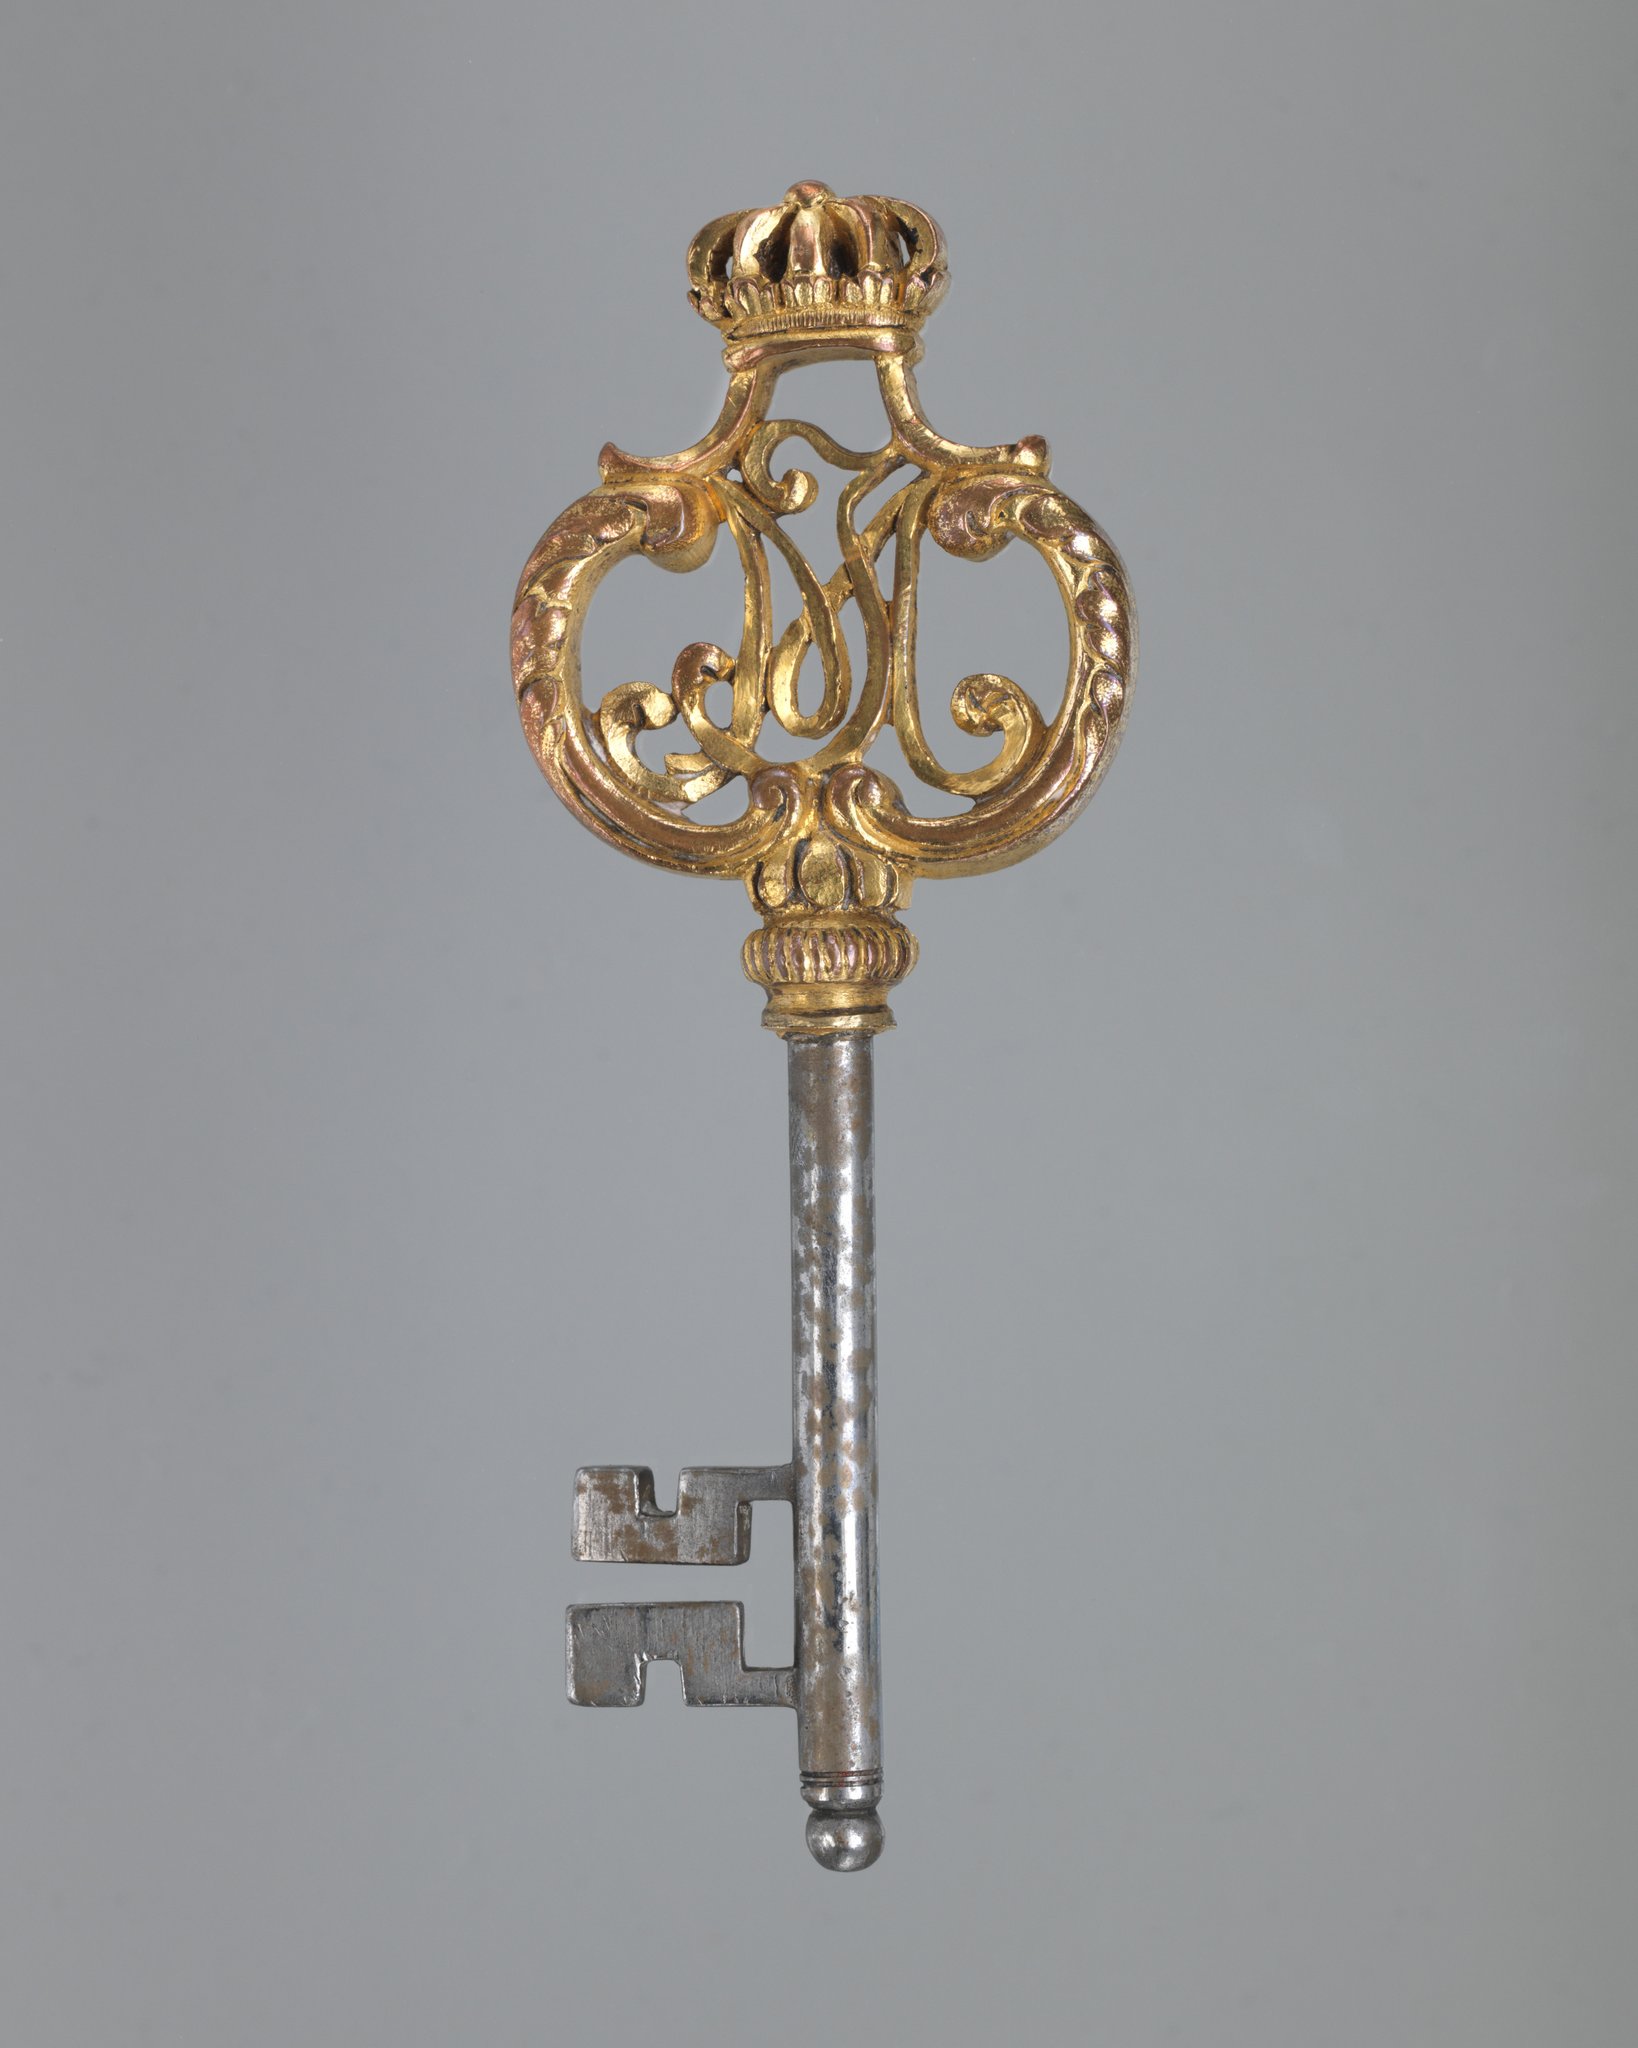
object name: key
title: Chamberlain's key with the monogram of Maximilian I Joseph, King of Bavaria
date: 1806-1826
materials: bronze, steel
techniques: gilding